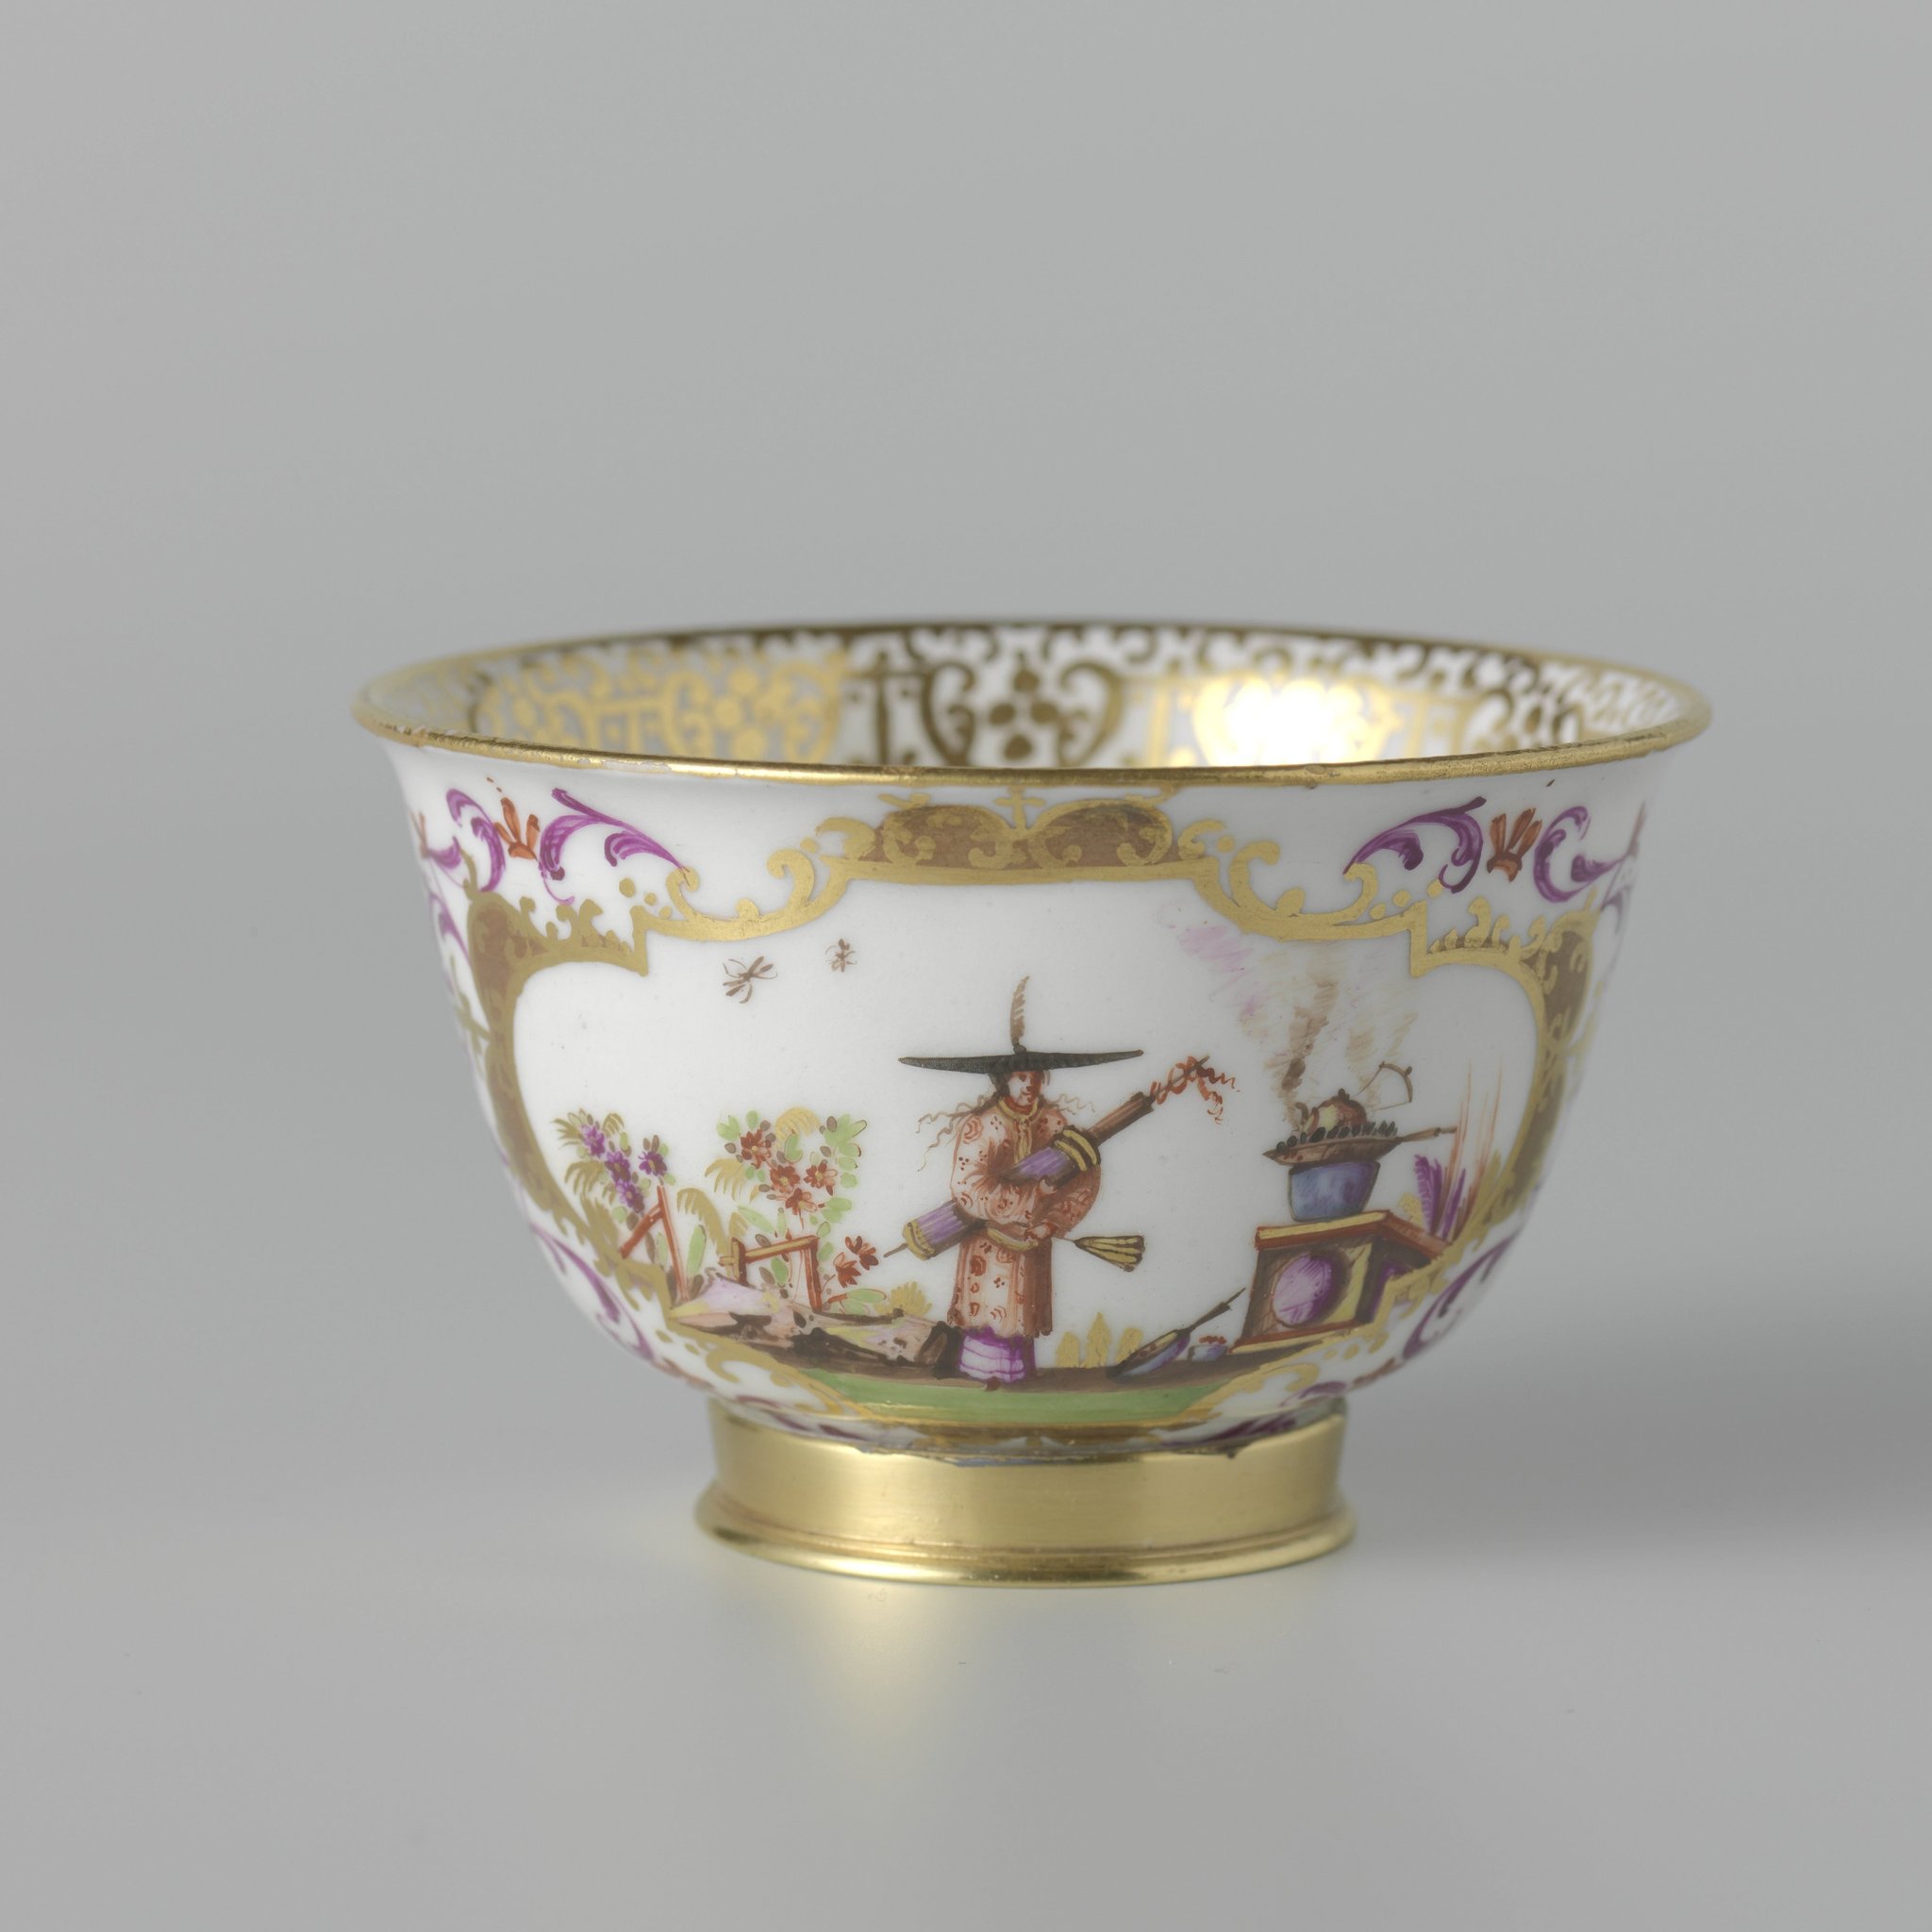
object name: cup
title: Kop, veelkleurig beschilderd met chinoiserieën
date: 1725-1730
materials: porcelain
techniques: painted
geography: meissen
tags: catharina de grote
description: Tea service on silver-gilt stand. Porcelain and silver gilt. Meissen, c. 1725 - 1730, the stand Augsburg, c. 1730, by Johannes Engelbrecht. From the possessions of Catharine the Great of Russia